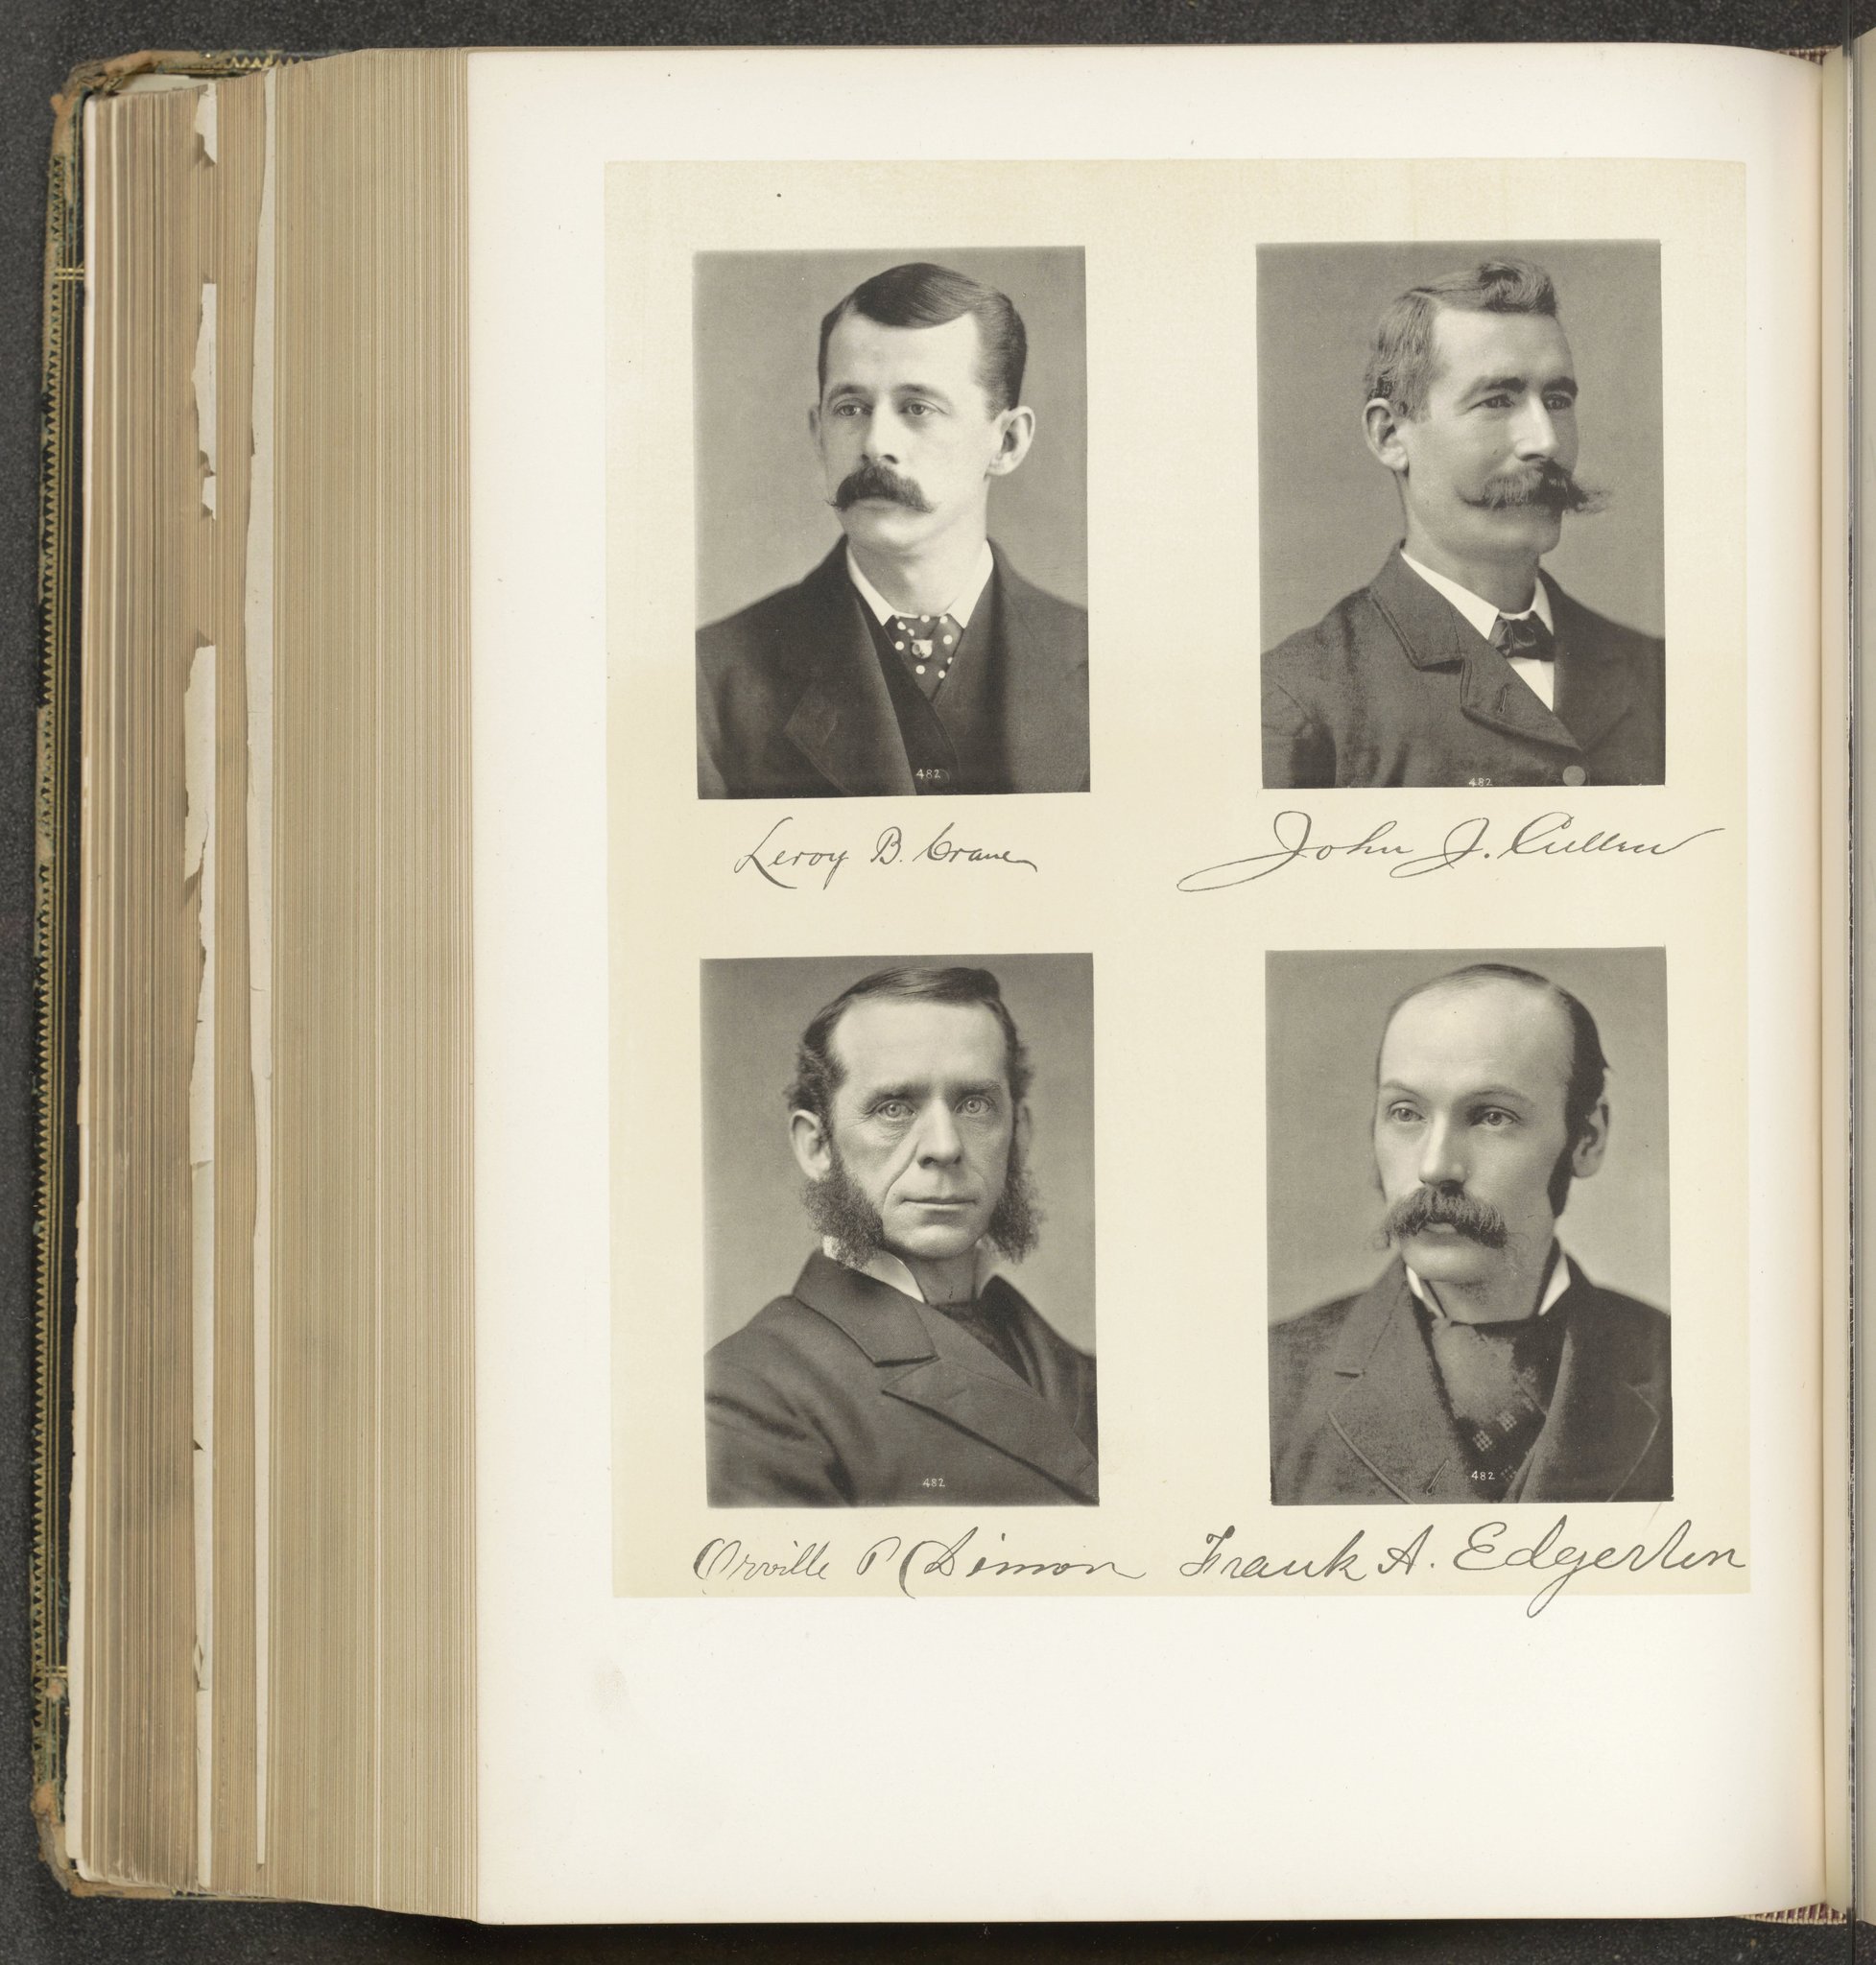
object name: photomechanical print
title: Portretten van vier leden van het Lagerhuis van de staat New York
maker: Anonymous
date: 1872-1882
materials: paper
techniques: photograph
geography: united states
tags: historical persons (portraits and scenes from the life) (+ head (and shoulders) (portrait))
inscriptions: annotation, number: ‘482’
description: Linksboven Leroy Bowers Crane, rechtsboven John J. Cullen, linksonder Orville P. Dimon, rechtsonder Frank A. Edgerton.